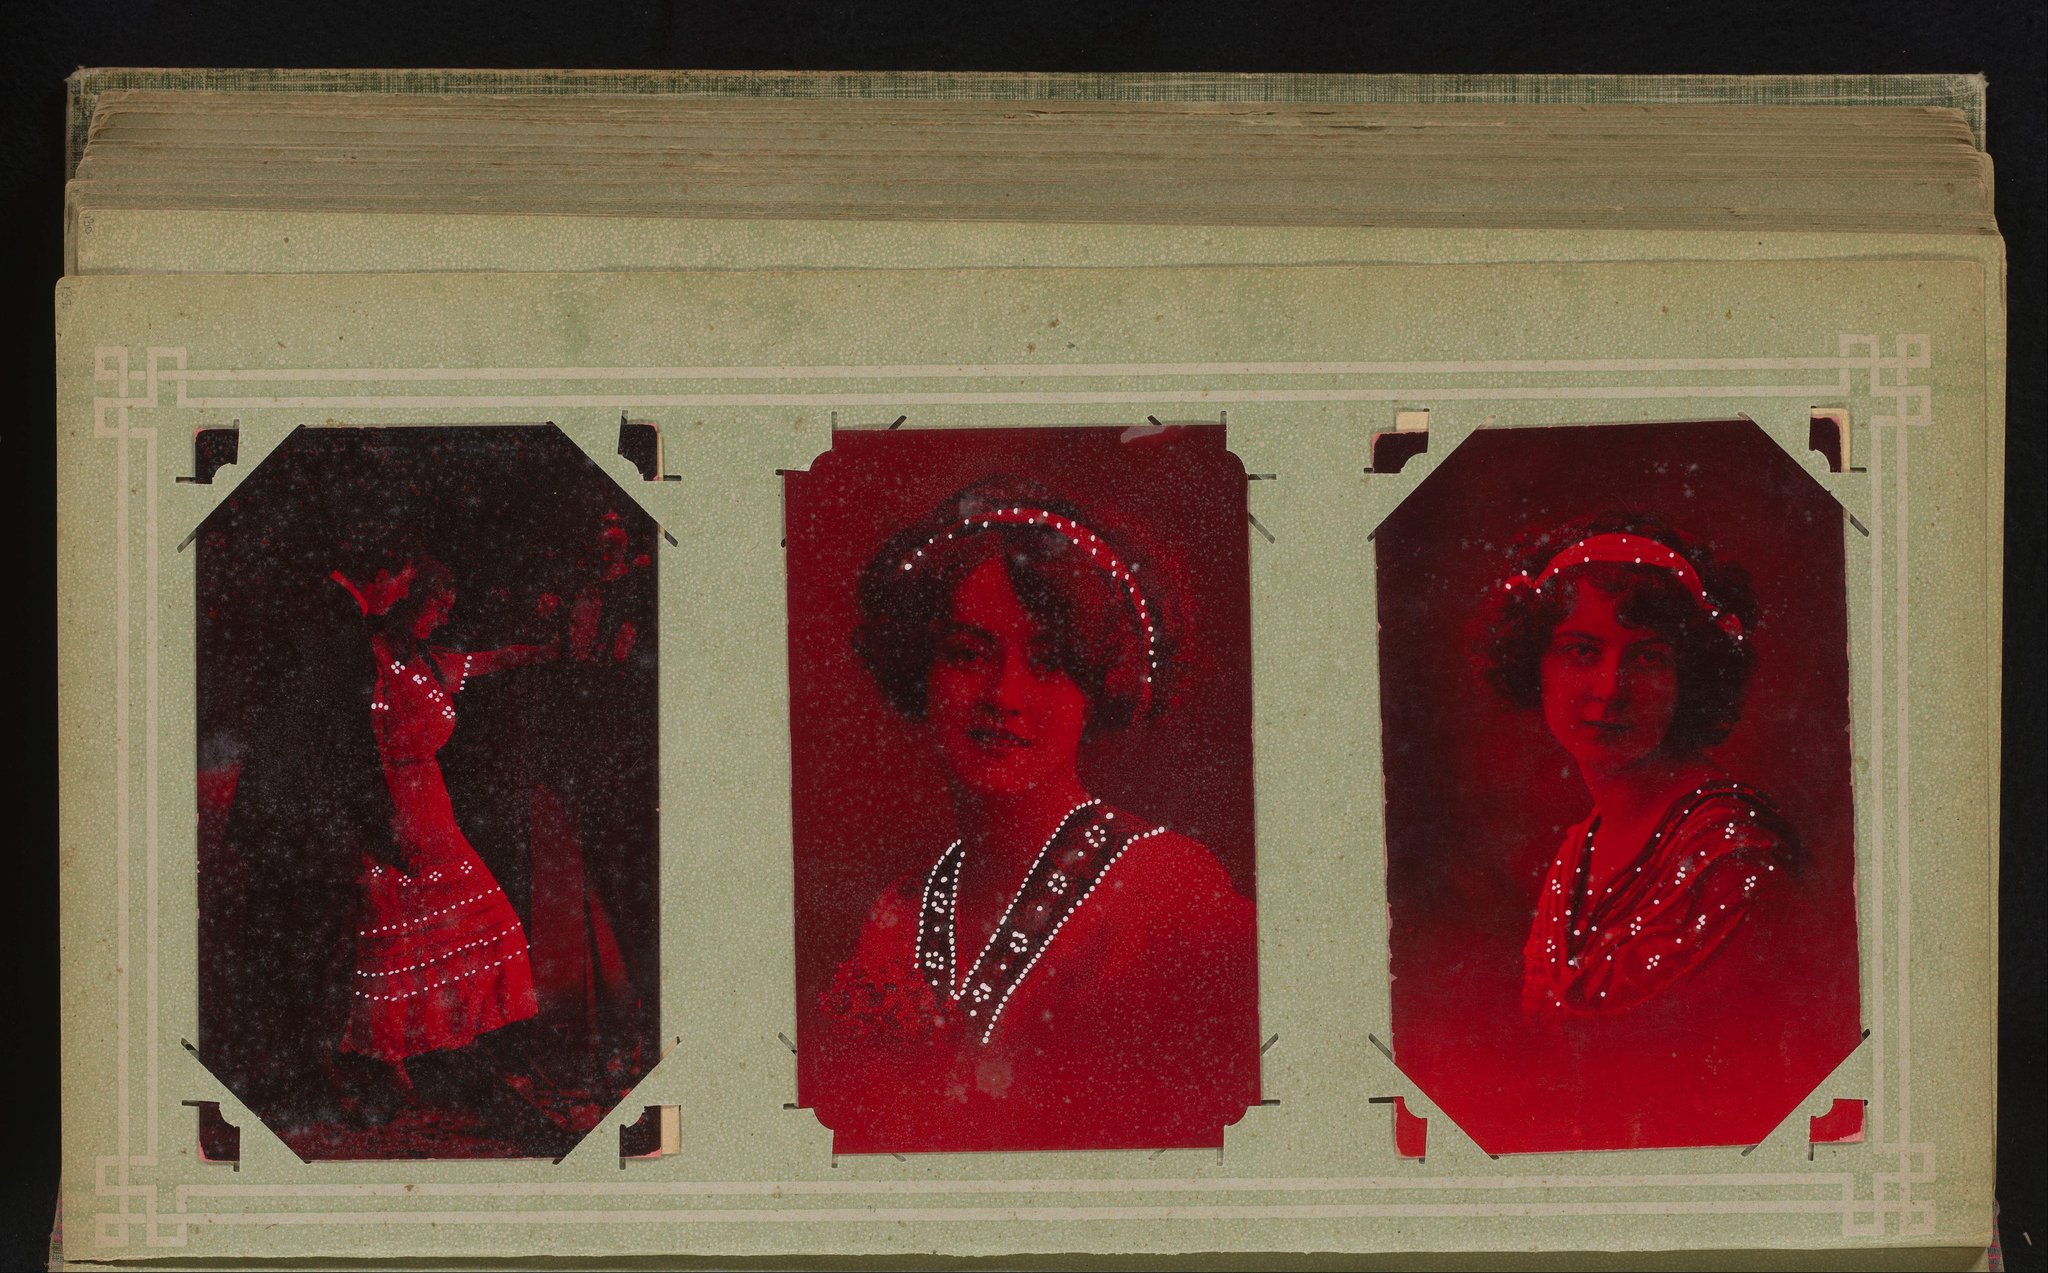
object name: album leaf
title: Drie portretten van vrouwen, waarvan één met een man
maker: Anonymous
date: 1900-1930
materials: cardboard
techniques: hand coloring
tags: historical persons - bb - woman, adult man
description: Deze prenten maken deel uit van een album.